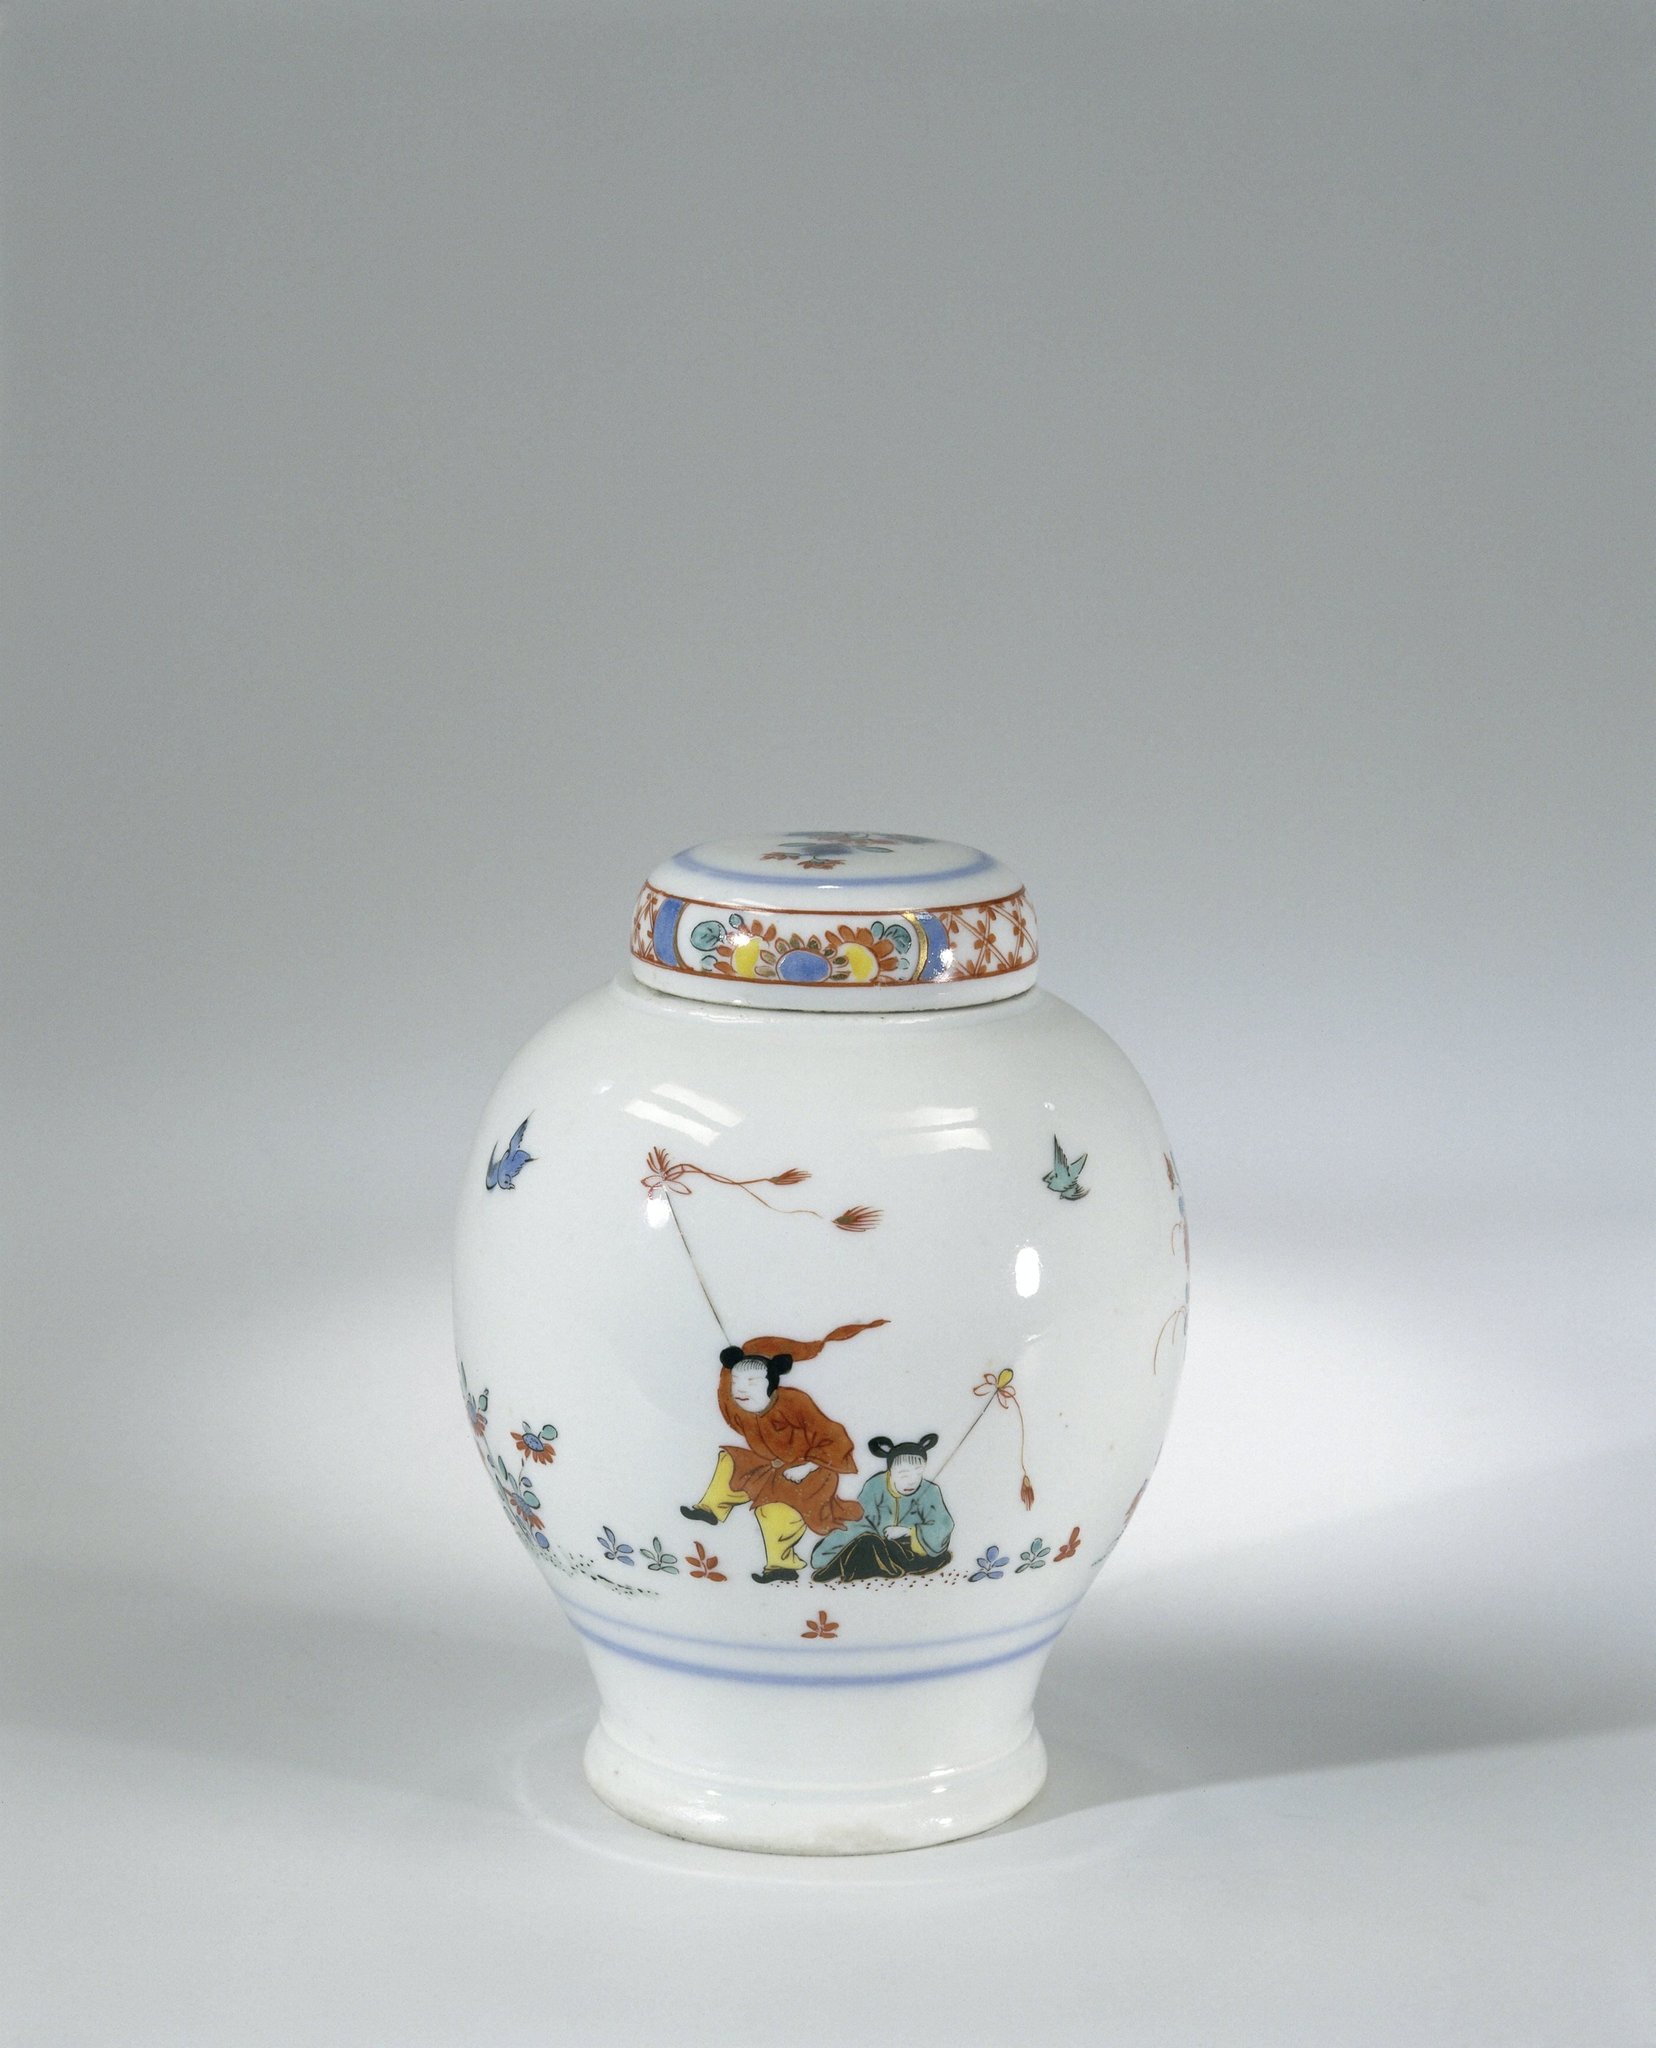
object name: eating drinking utensil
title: Theebus met deksel, veelkleurig beschilderd met chinoiserieën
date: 1730-1735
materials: porcelain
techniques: painted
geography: meissen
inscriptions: mold mark: ‘X (Rückert 1996, afb. 6, nr. 33)’, factory mark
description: Tea caddy. Porcelain. Meissen, c. 1730 - 1735, decorated by Adam Friedrich von Löwenfinck.